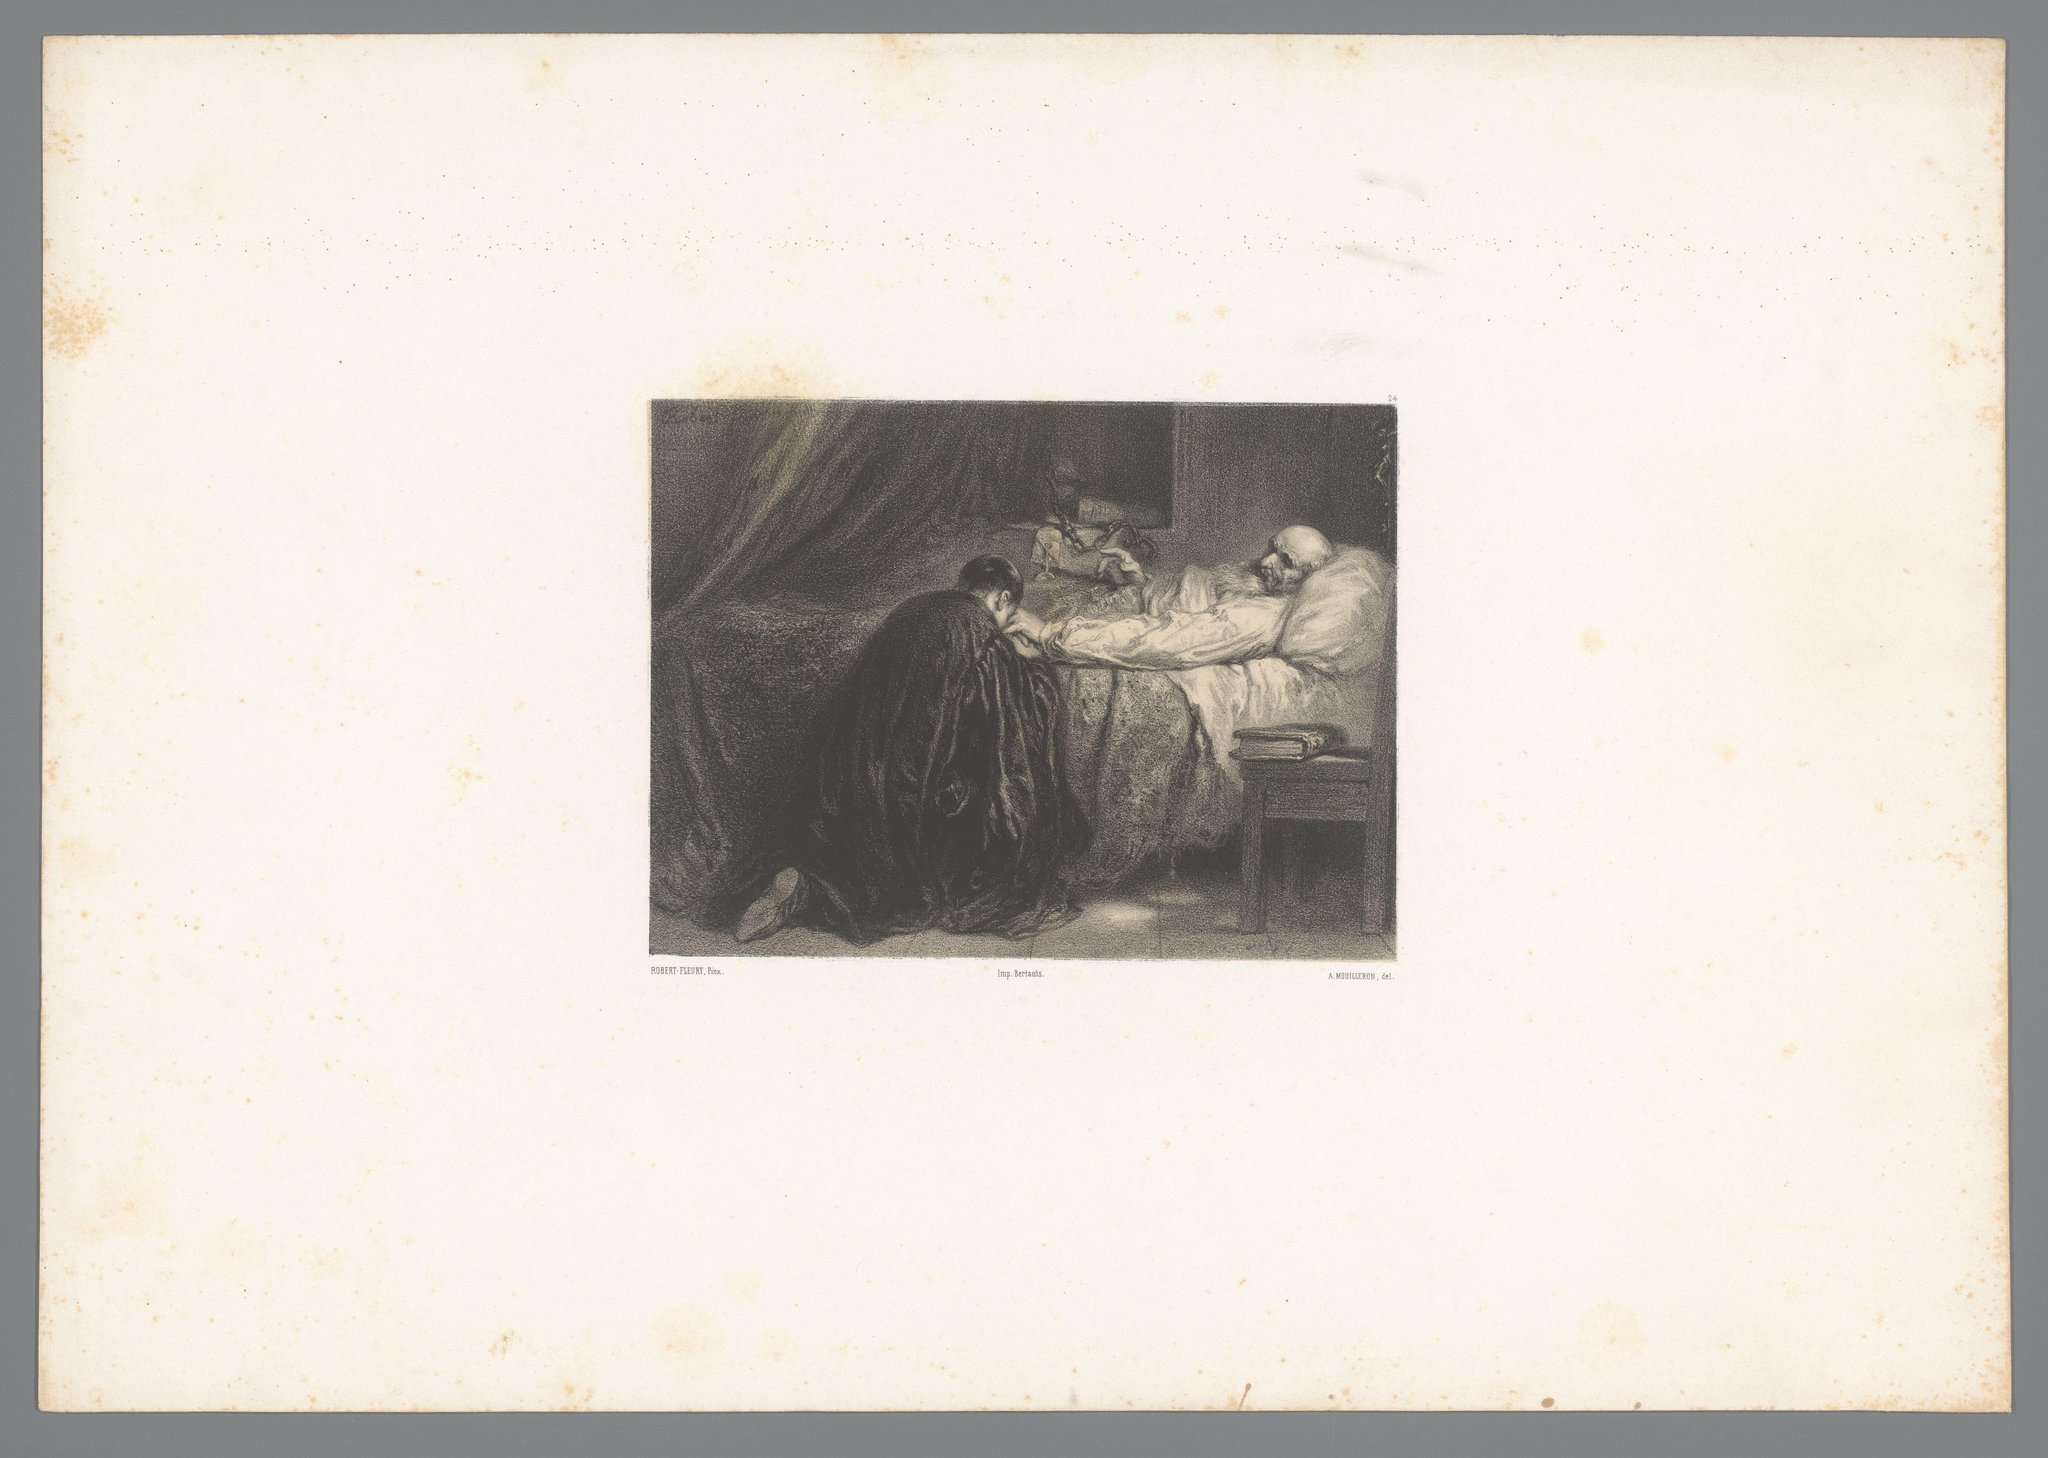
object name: print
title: Eigentijdse kunstenaars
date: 1847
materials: paper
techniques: lithograph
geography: paris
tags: deathbed, historical persons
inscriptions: collector's mark: Lugt 964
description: Serietitel en jaartal gebaseerd op publicatie waarin prent wordt genoemd: Bibliographie de la France (1847), nr. 10, 6 maart 1847, p. 119.